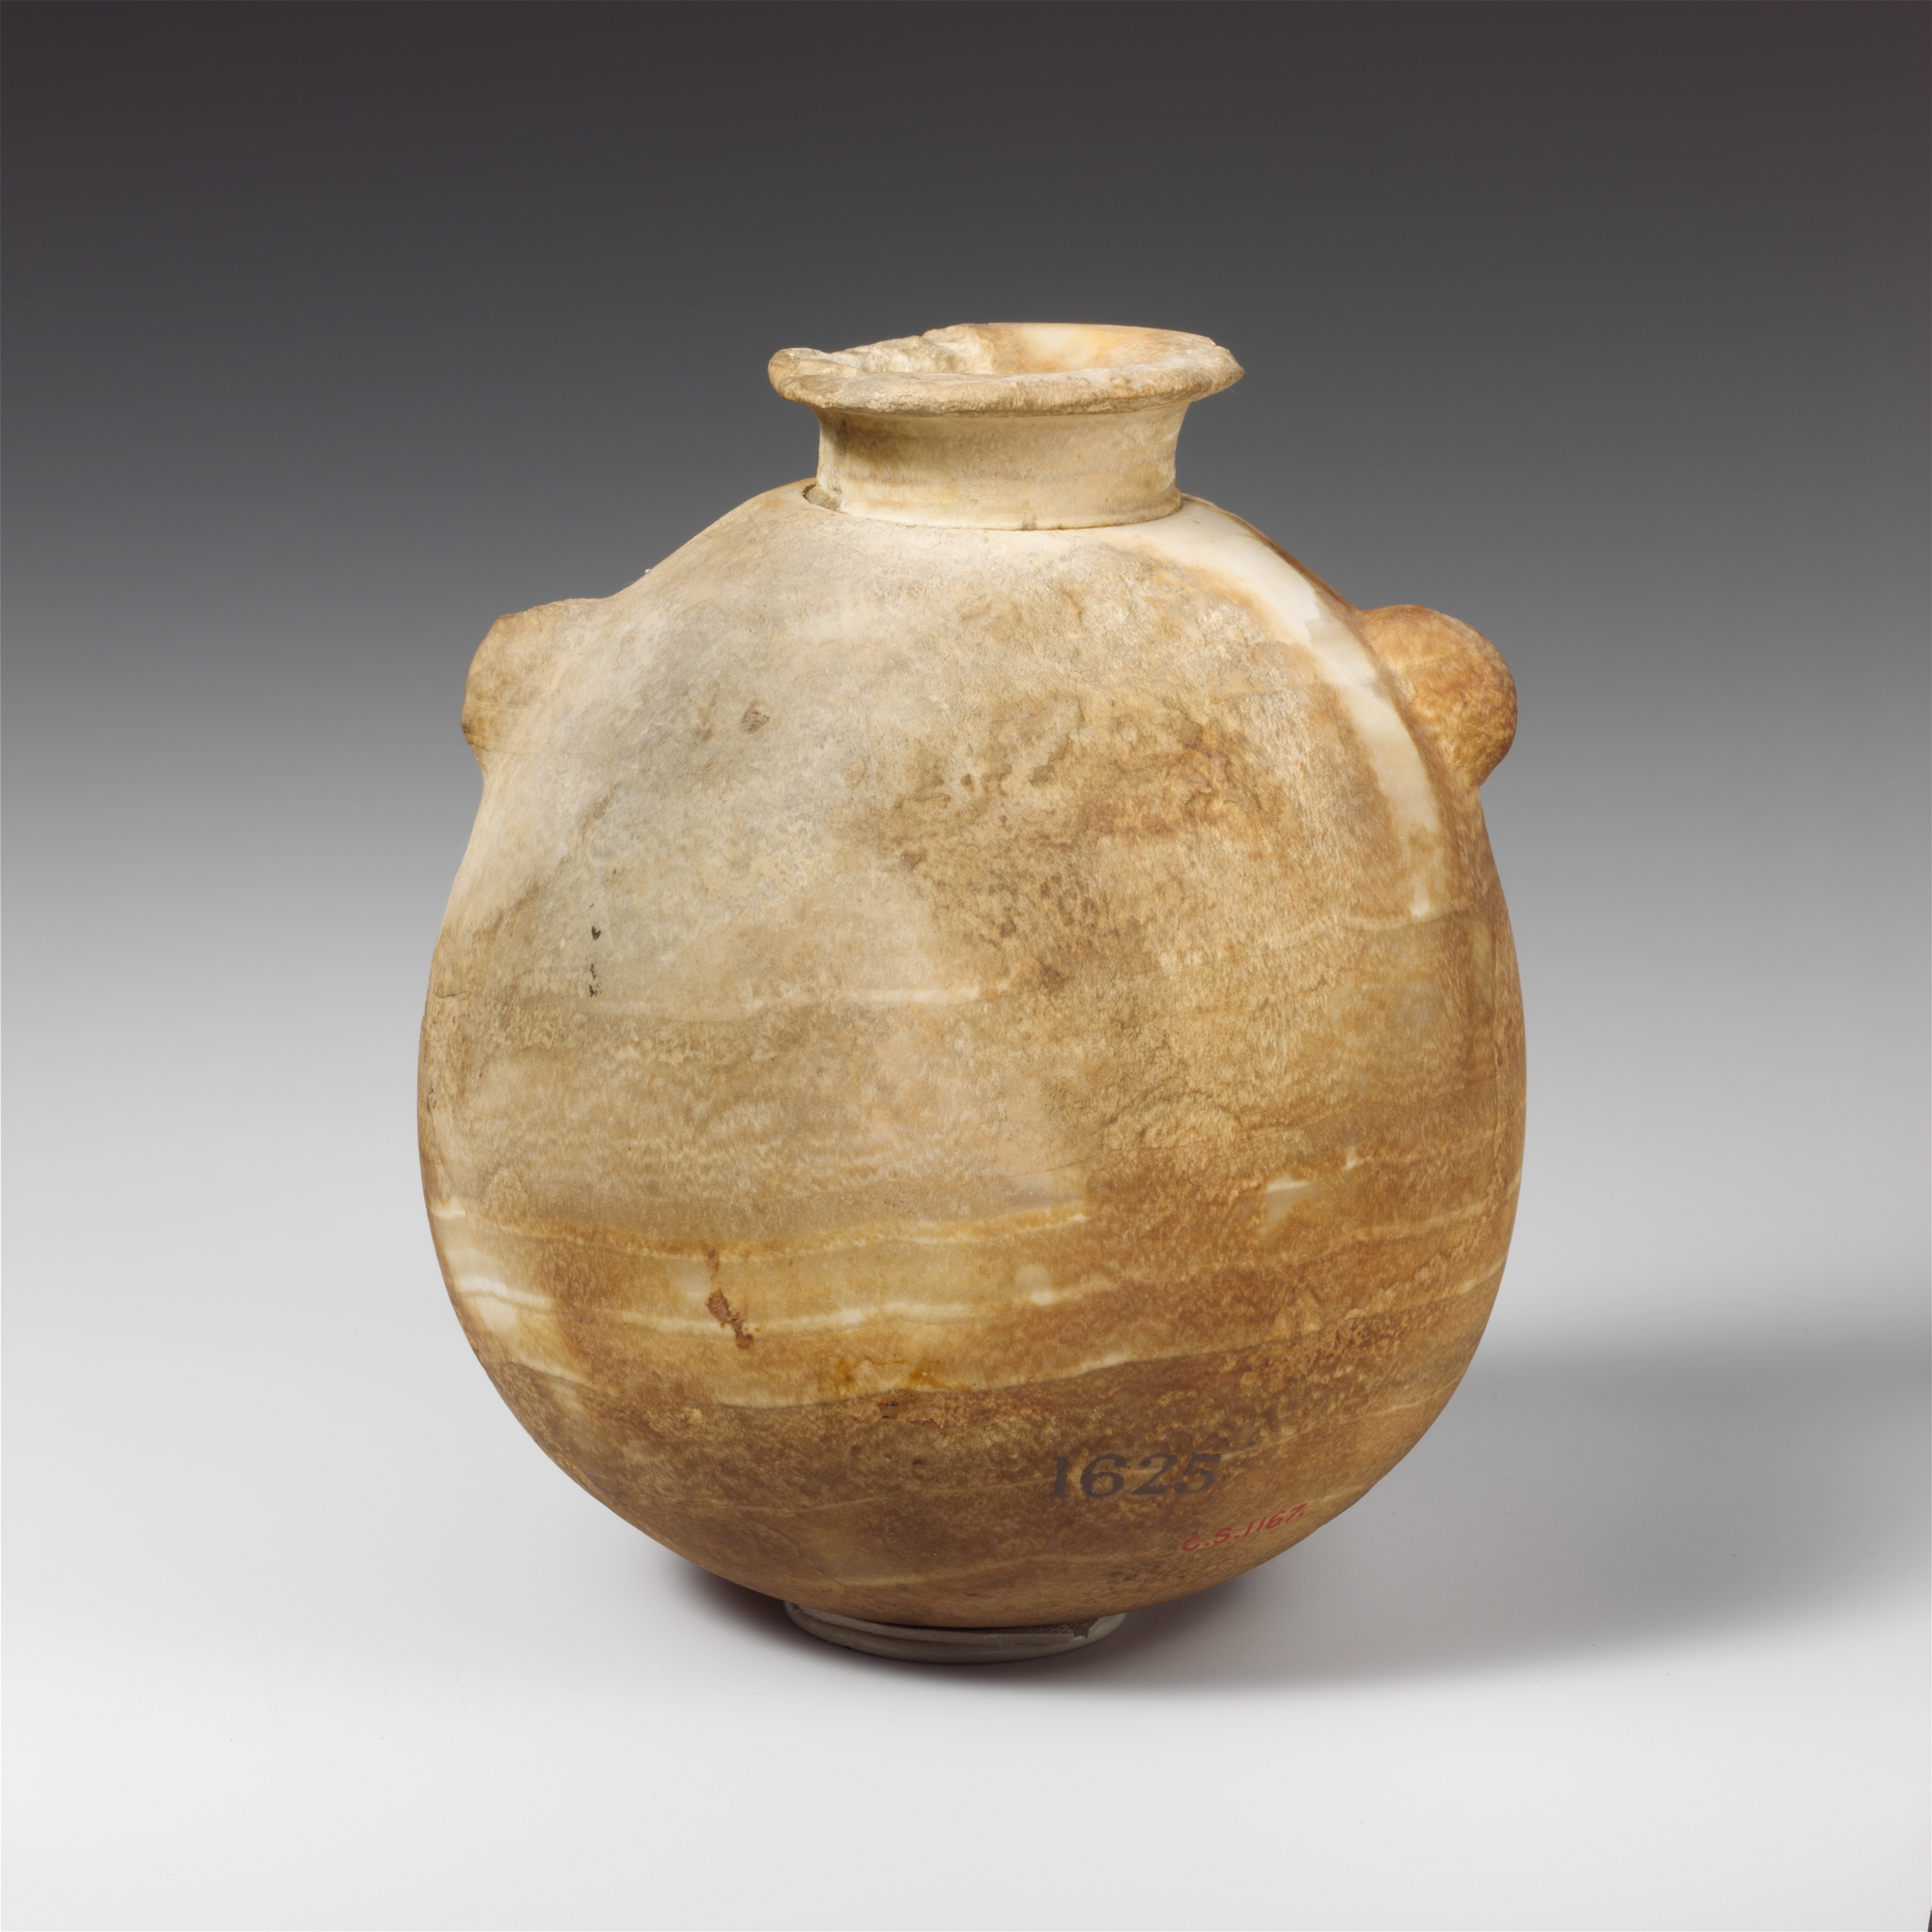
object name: vase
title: Alabaster alabastron (perfume vase)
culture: cypriot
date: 600-401 BCE